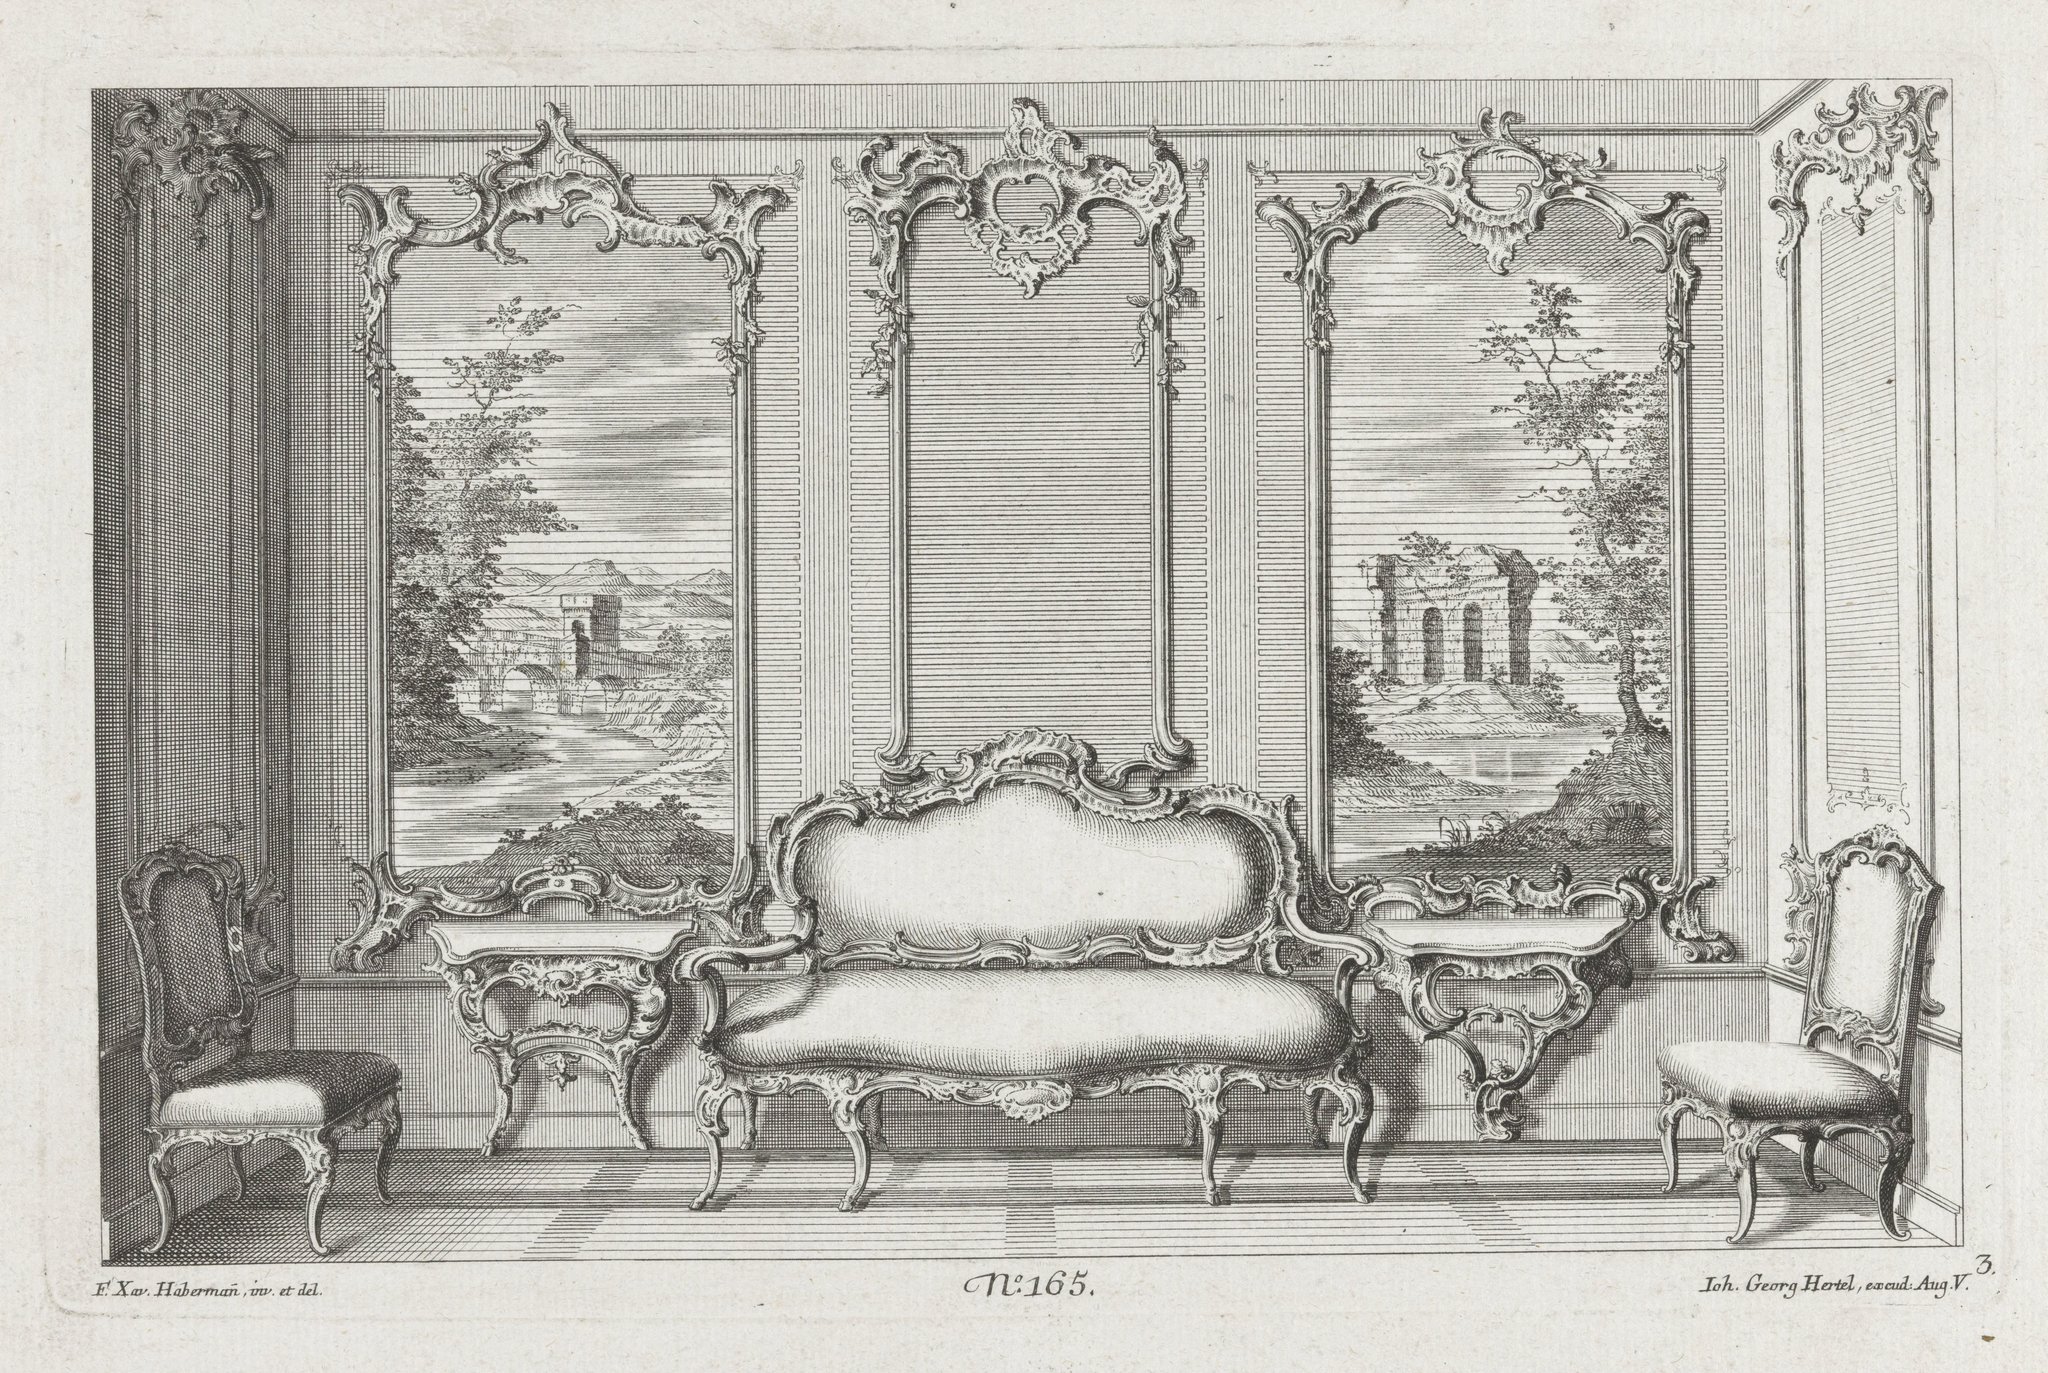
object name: ornament print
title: Interieur met bank en stoelen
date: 1731-1775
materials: paper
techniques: engraving, etching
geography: augsburg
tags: rocaille ornament, interior of the house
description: Interieur met panelen met beschildering of wandtapijt, een bank, twee tafels en twee stoelen. Alles met rocaille ornamenten gedecoreerd. Uitgeversnummer 165.